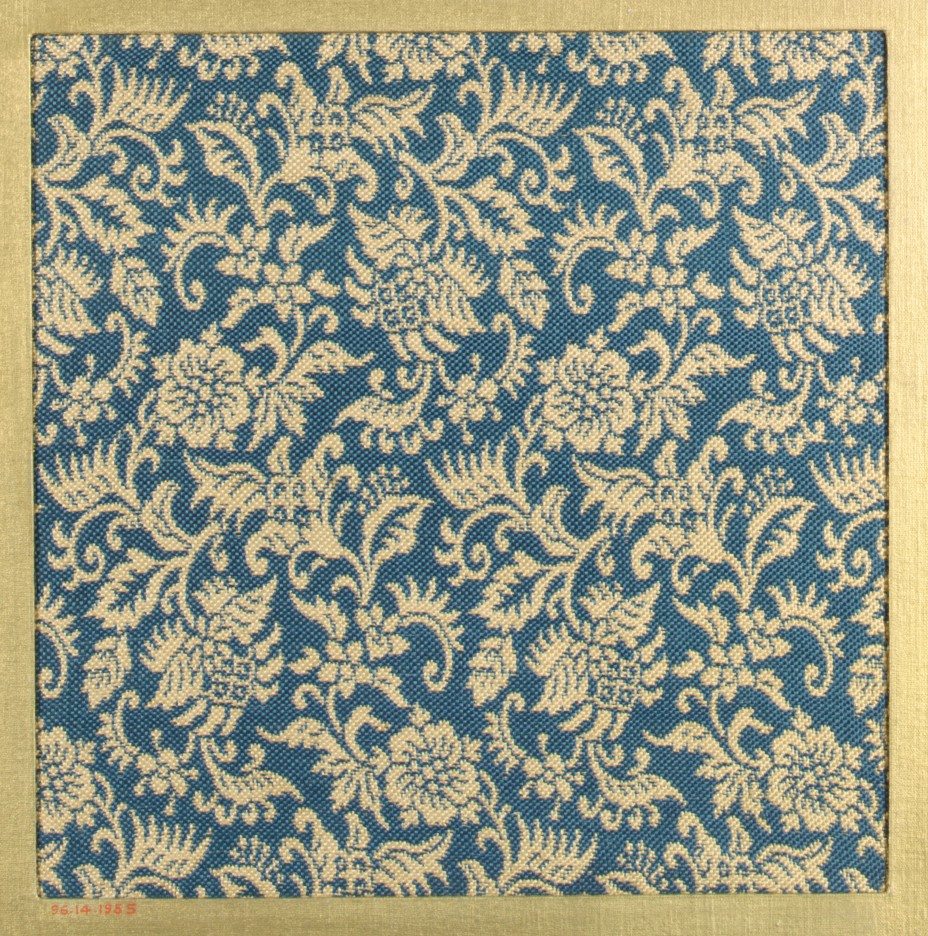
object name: piece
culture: japanese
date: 1701-1900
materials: silk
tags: leaves